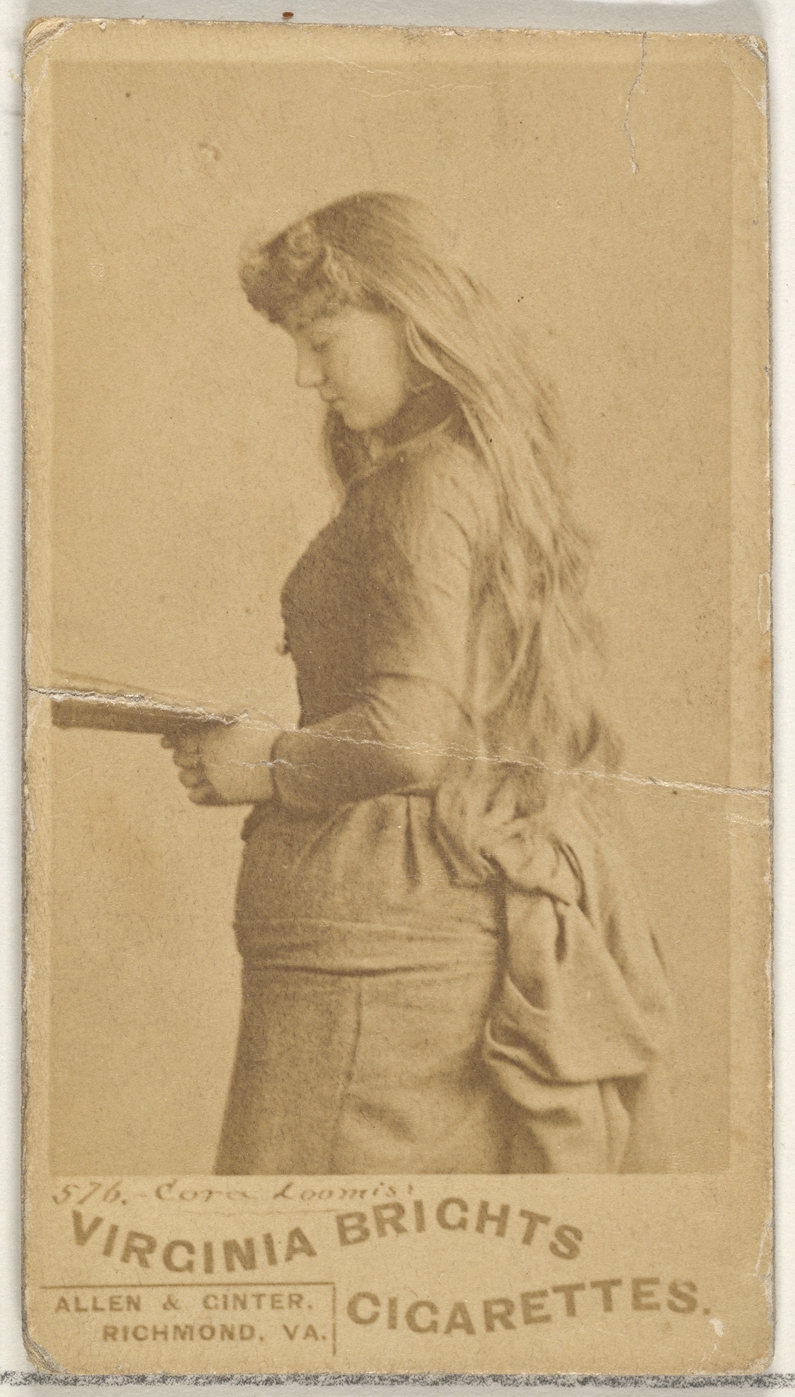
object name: photograph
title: Card 576, Cora Loomis, from the Actors and Actresses series (N45, Type 1) for Virginia Brights Cigarettes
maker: allen & ginter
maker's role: publisher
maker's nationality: american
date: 1888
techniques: albumen silver print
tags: portraits,profiles,women,actresses